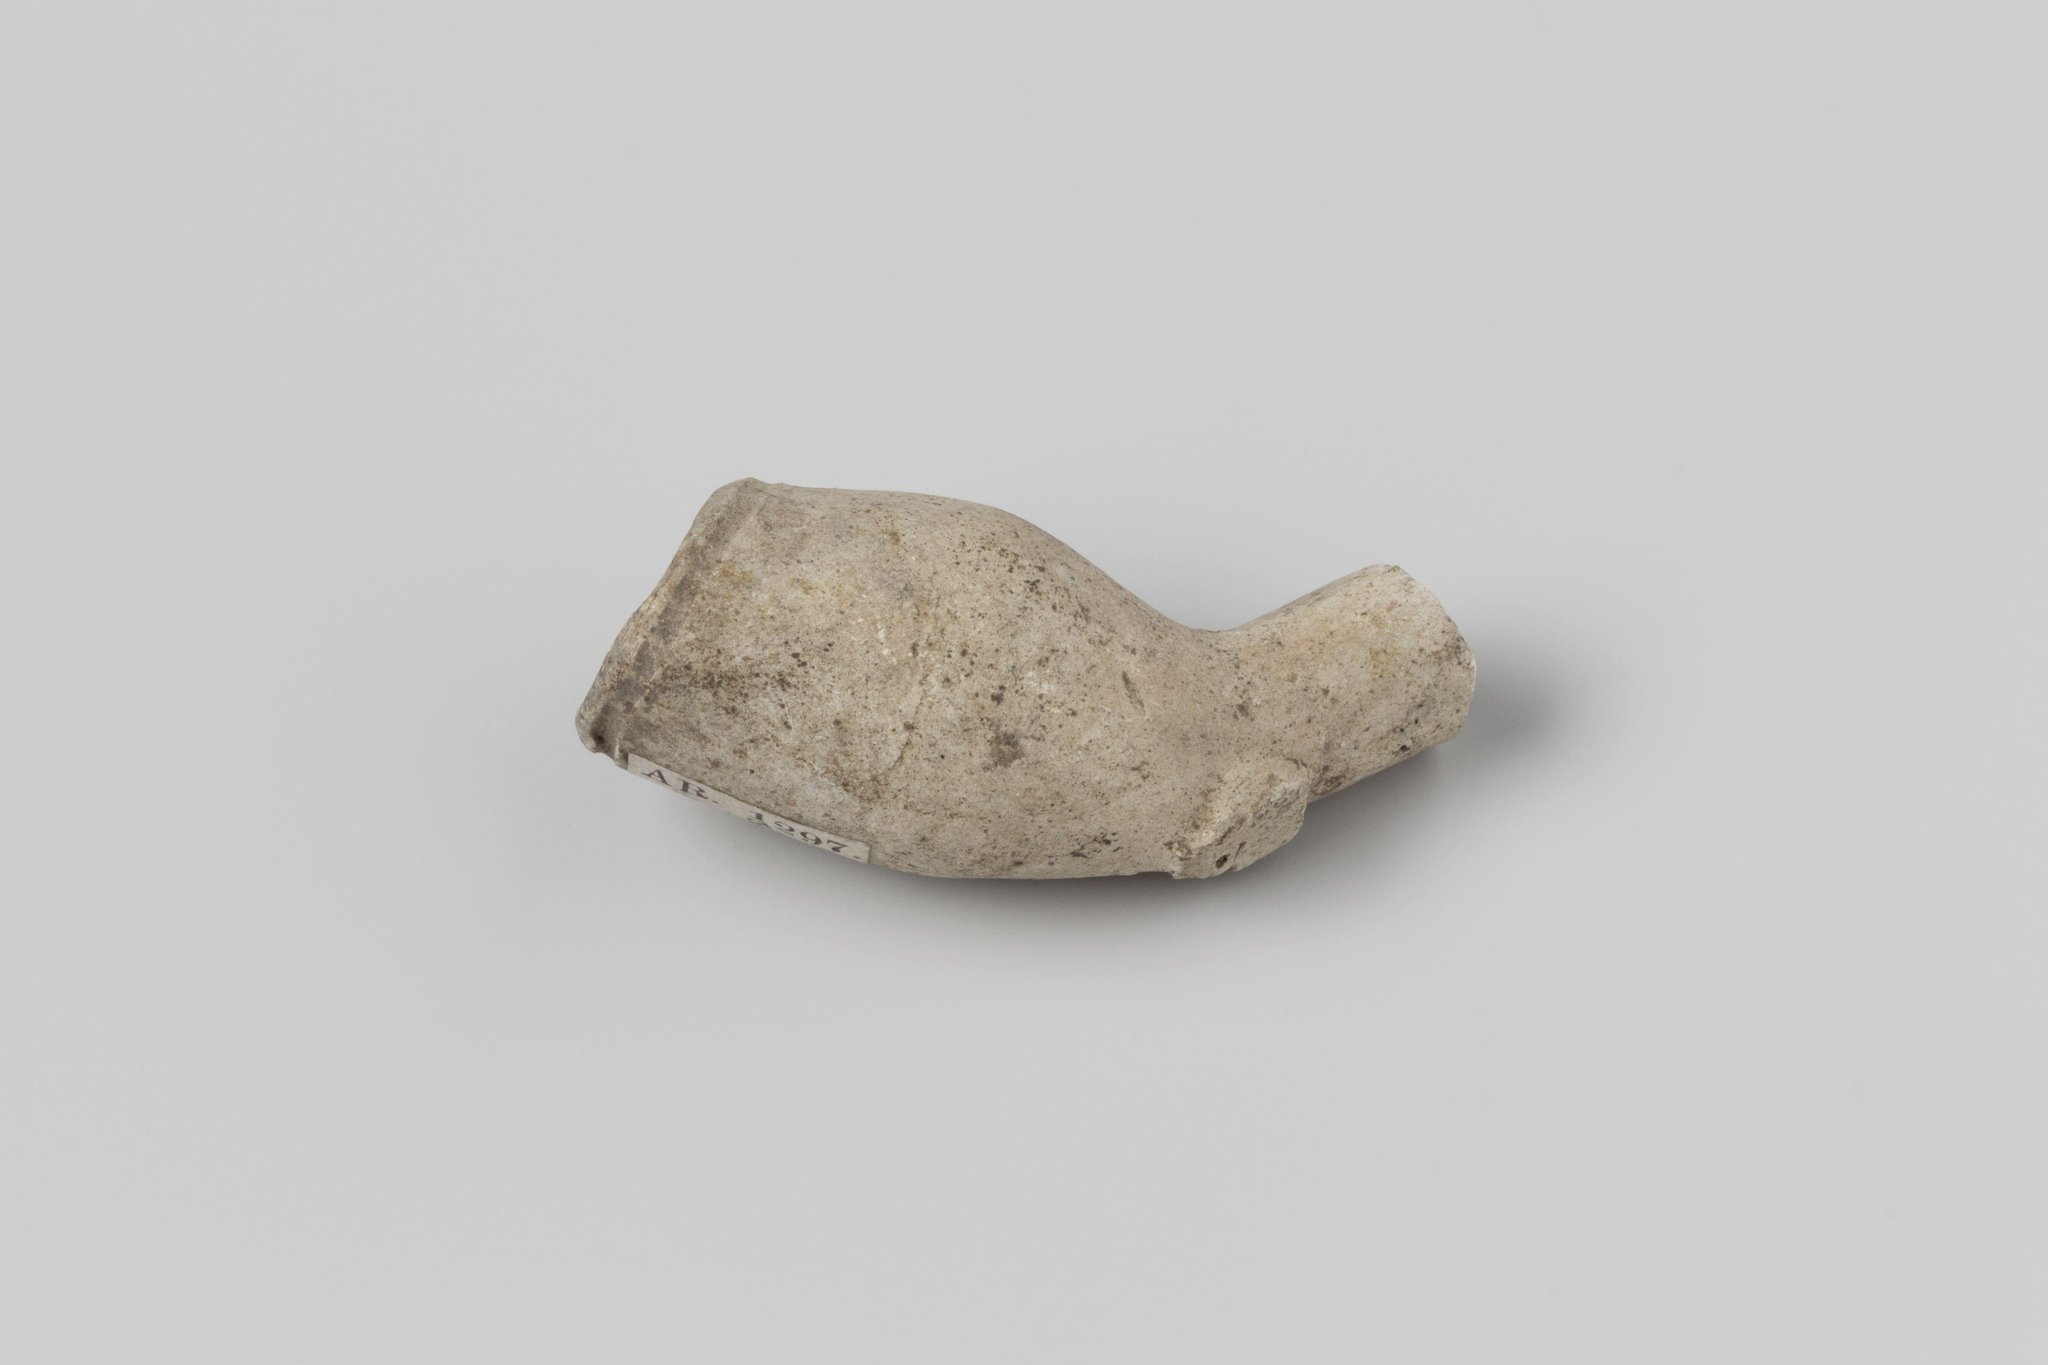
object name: pipe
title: Fragment tabakspijp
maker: Anonymous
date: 1600-1699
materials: clay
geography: netherlands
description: Fragment tabakspijp. Van de opgravingen op de Hofstede Arentsburg 1827-1831 onder toezicht van Professor Reuvens.